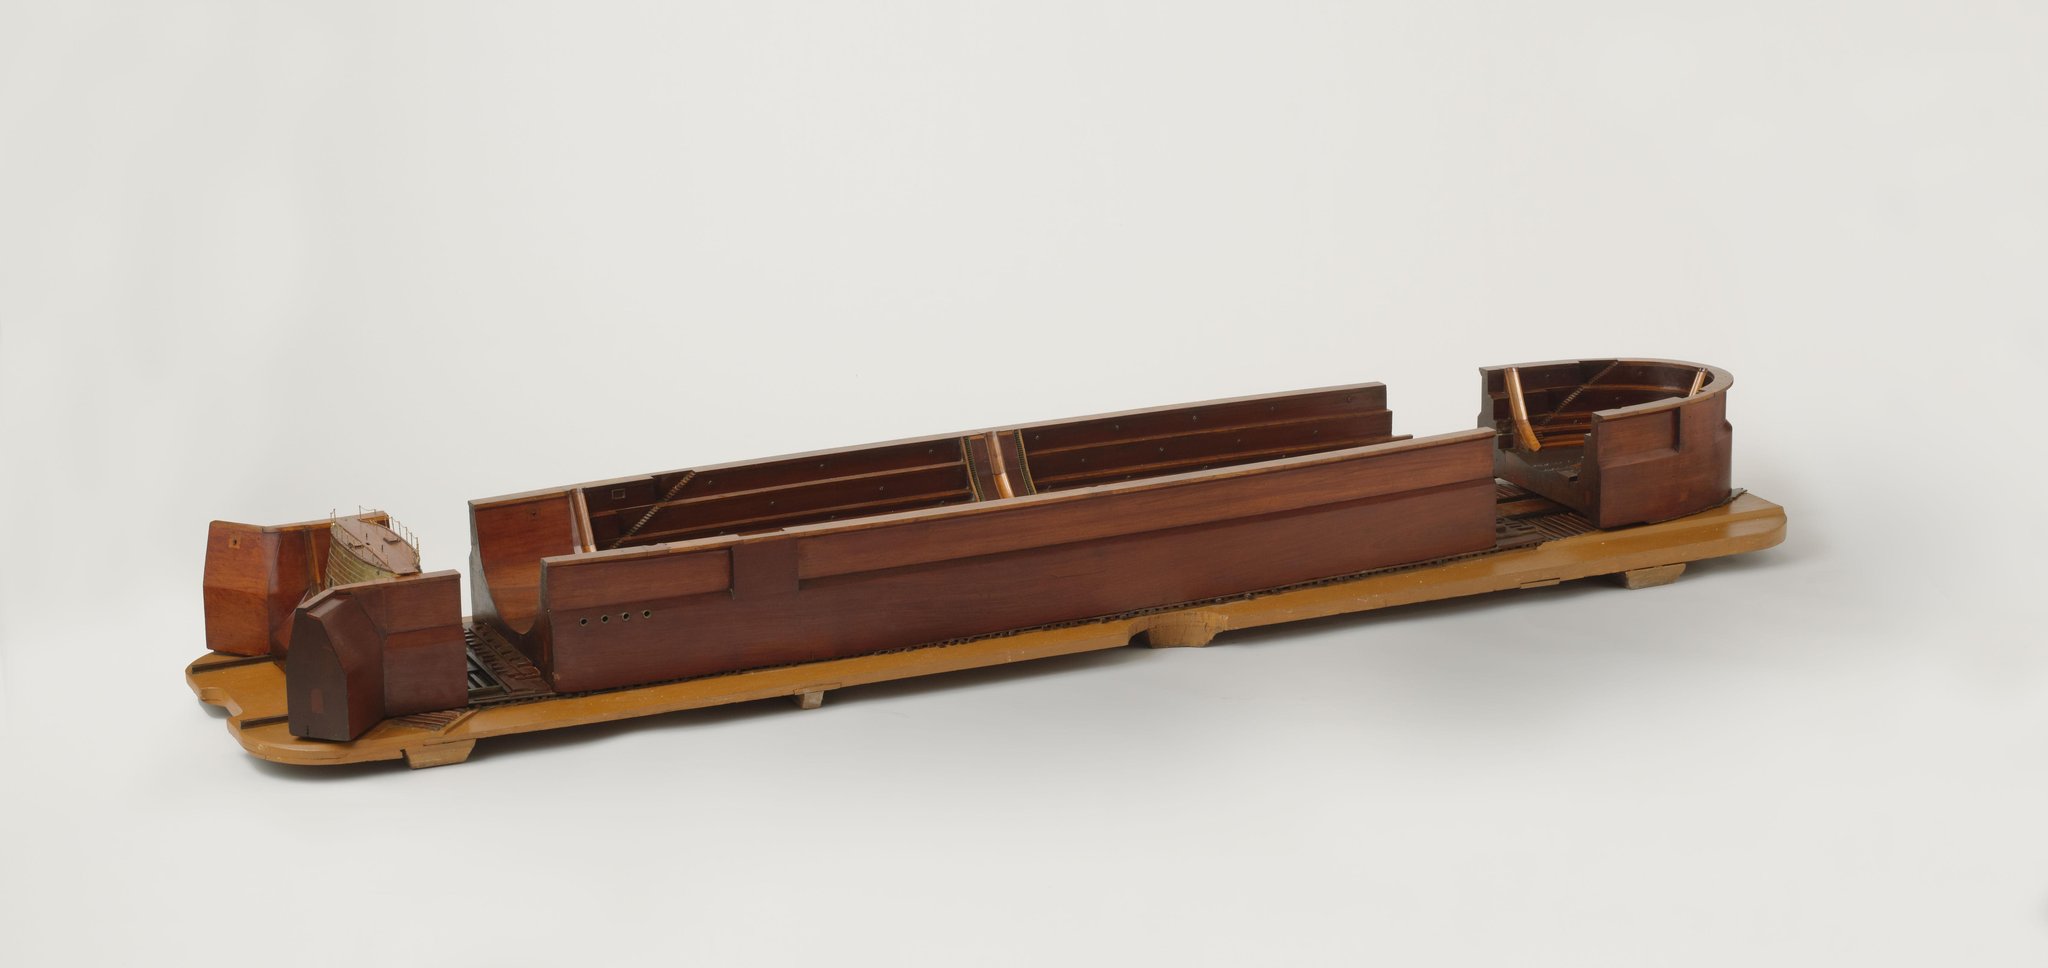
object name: demonstration model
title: Model of a Dry Dock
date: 1866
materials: brass, wood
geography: den helder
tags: den helder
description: Het droogdok van Willemsoord, lang 109 m, werd in 1864-1866 gebouwd; het werd op een niet-onderheid houten vlot gebouwd, maar ondanks de zeer verstevigde constructie boog het door onder de opwaartse druk van het grondwater en moest met 22 cm ijzer geballast worden, waardoor het aan diepgang verloor.